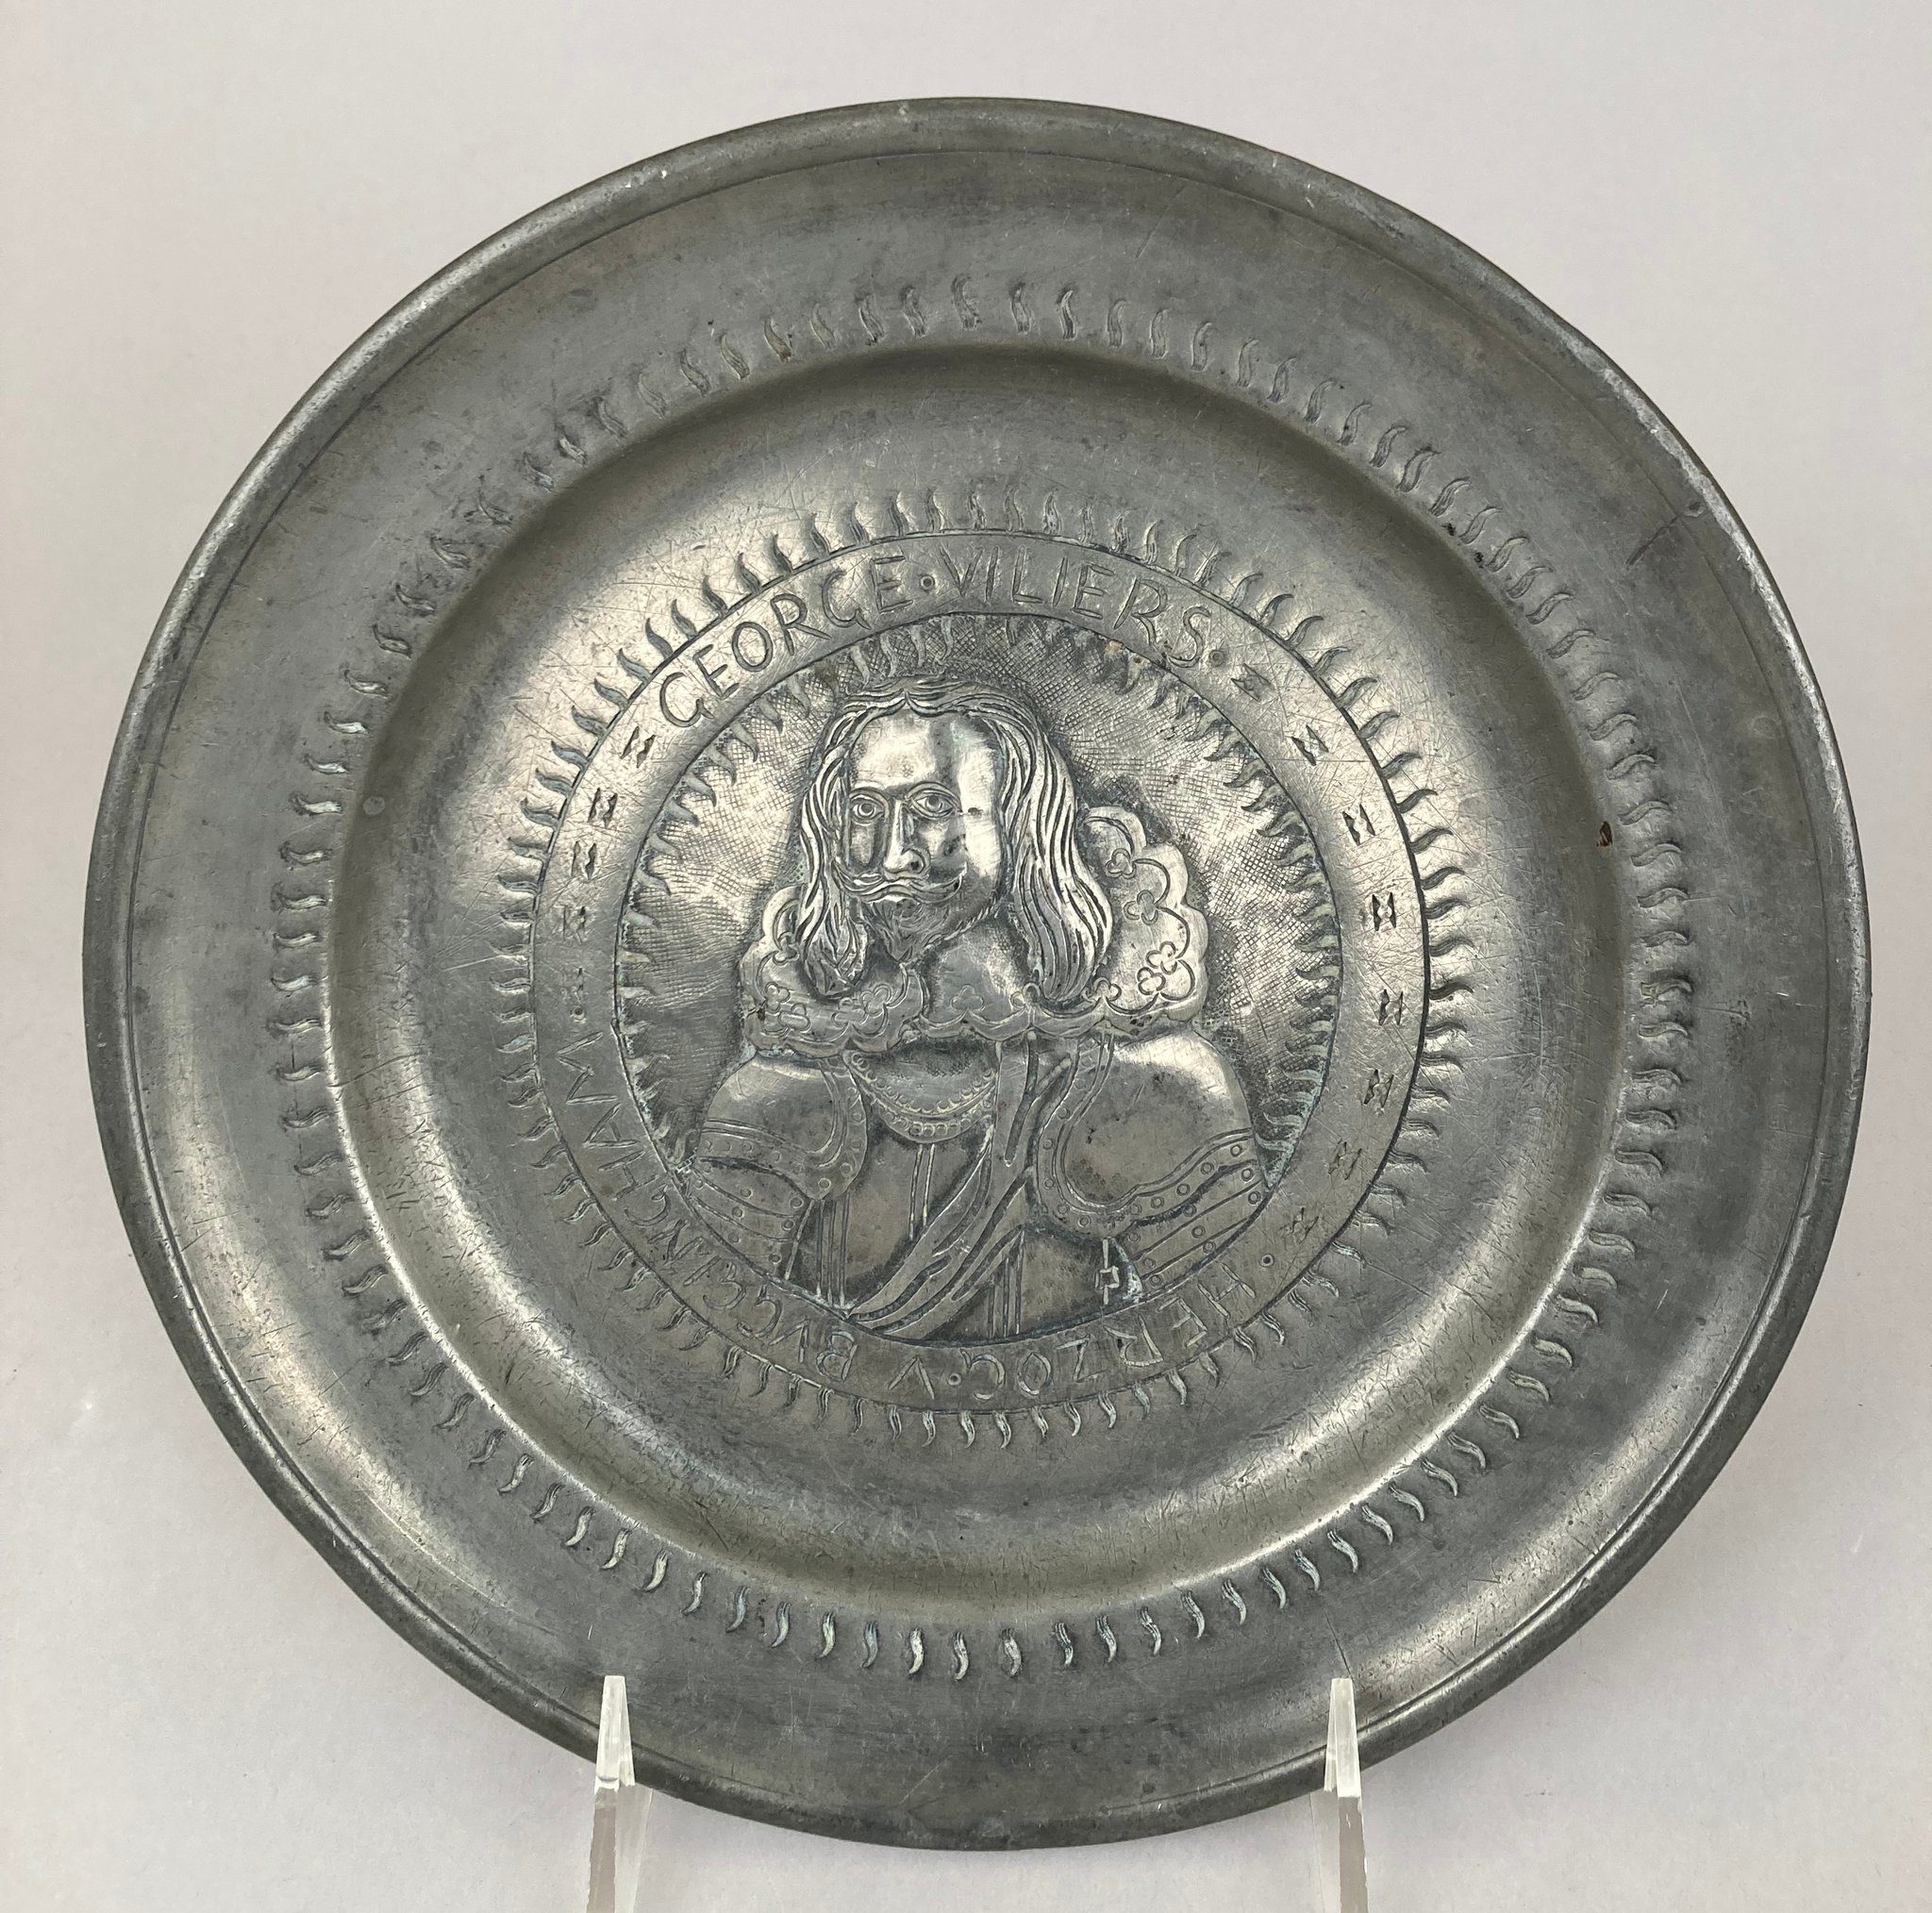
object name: plate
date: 1701-1800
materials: pewter